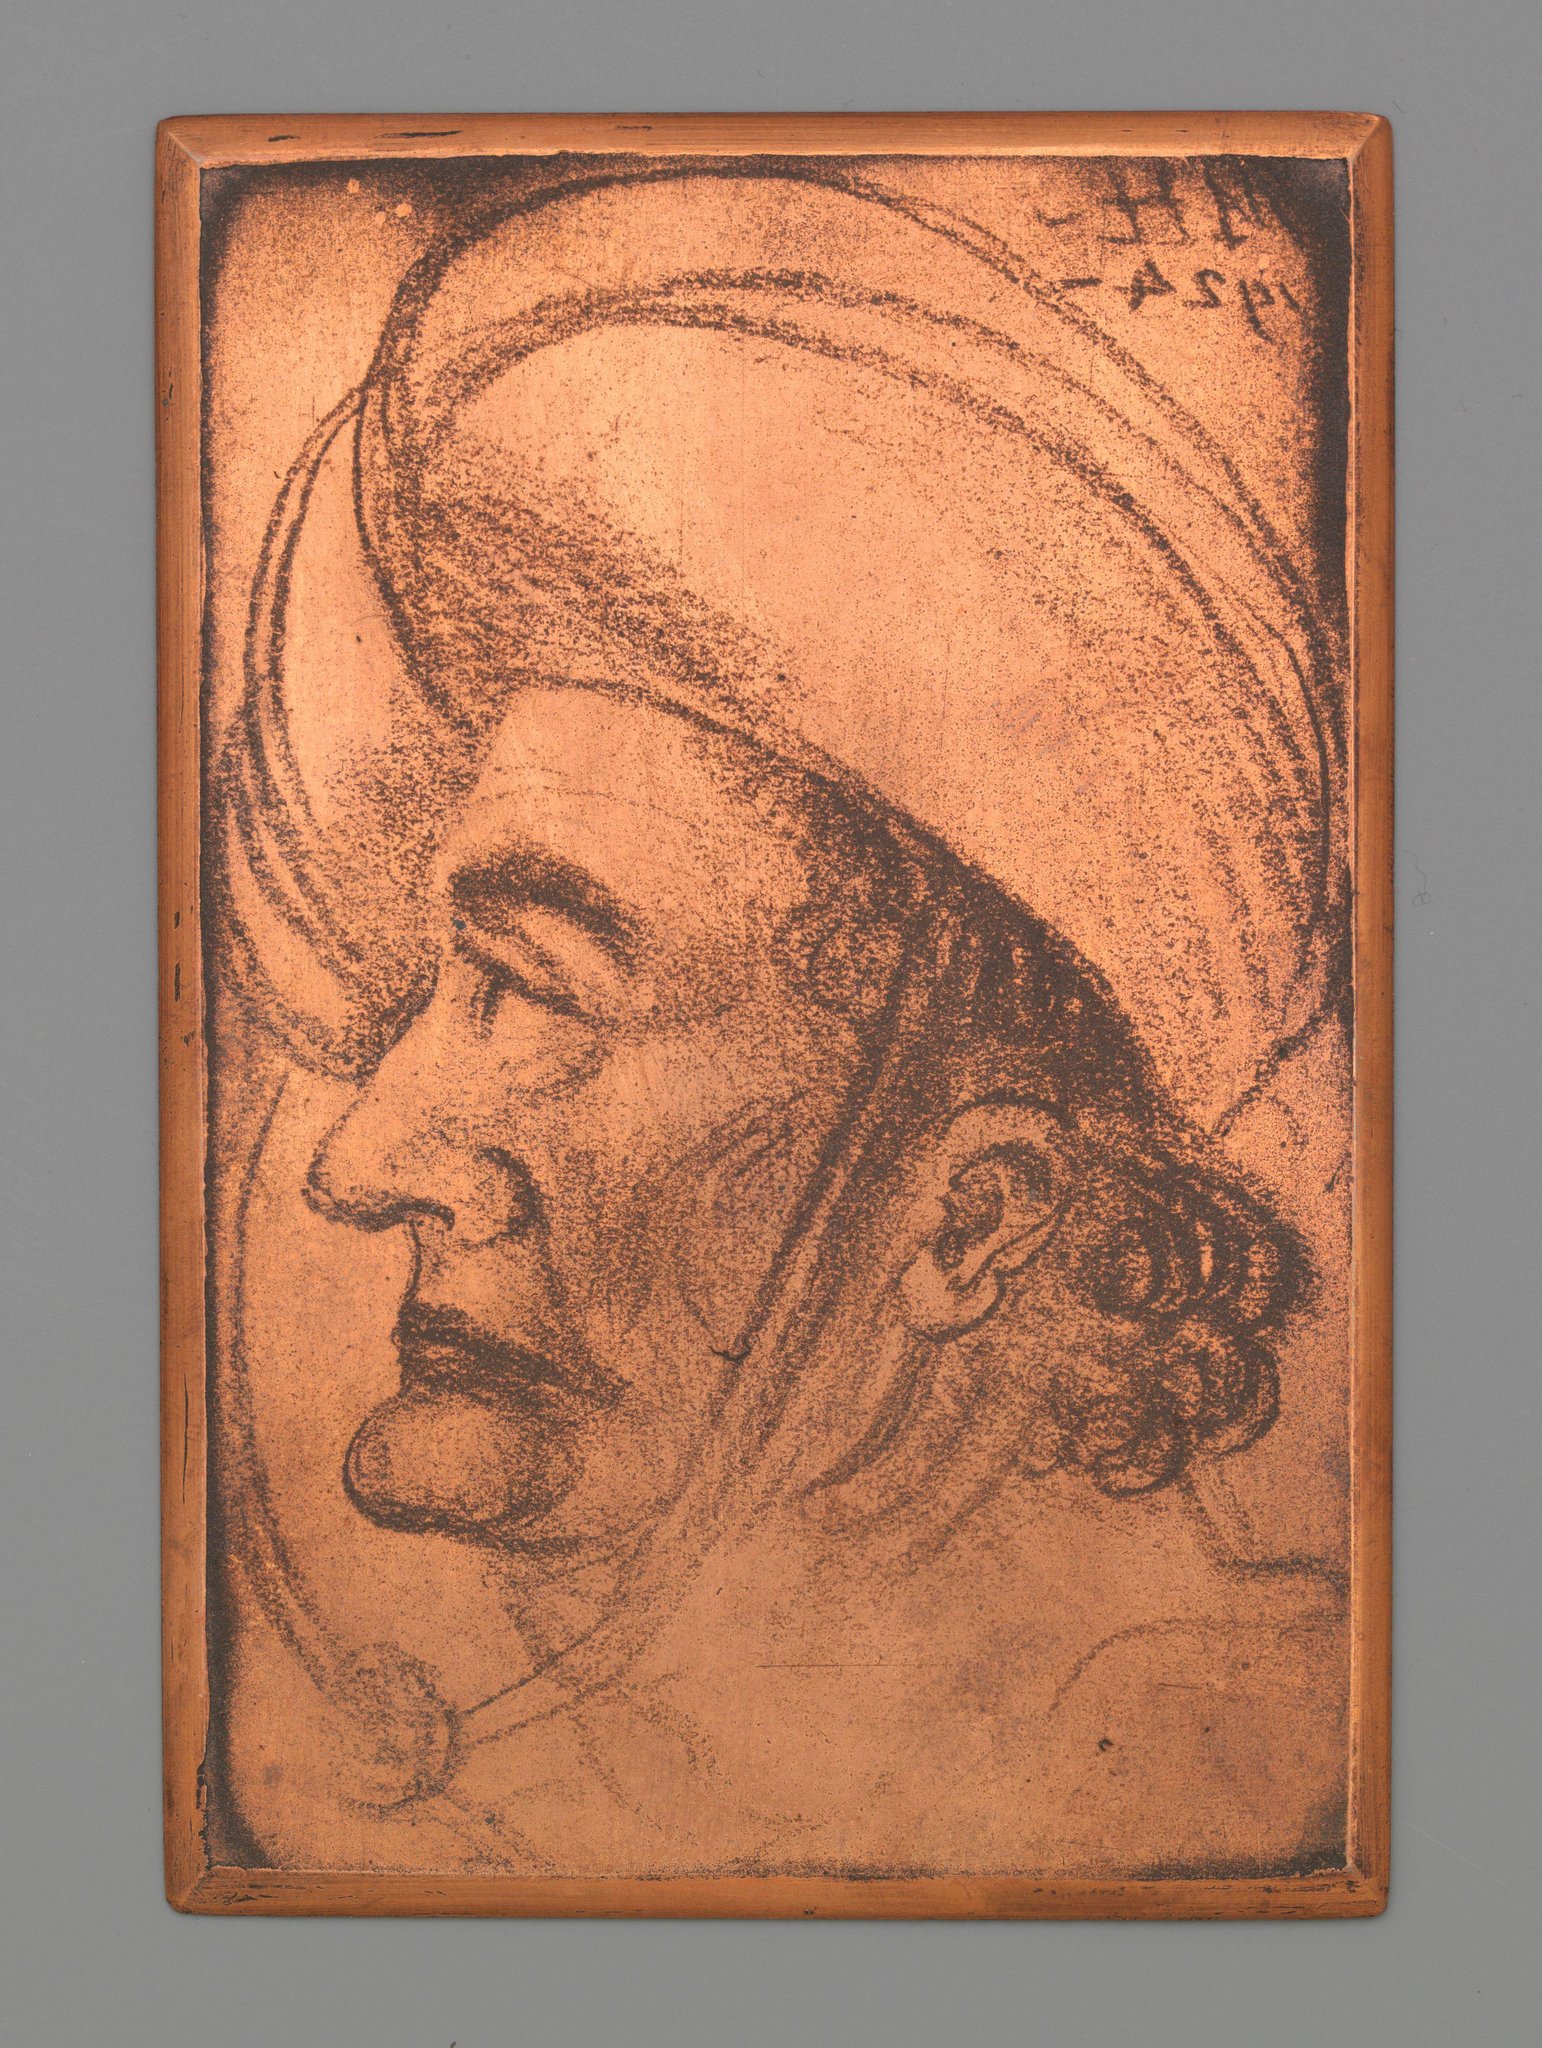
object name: copper plate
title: Hoofd van een man met tulband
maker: marius holleman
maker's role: draughtsman, print maker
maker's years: 1878-1926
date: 1924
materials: copper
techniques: soft ground etching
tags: head-gear: turban